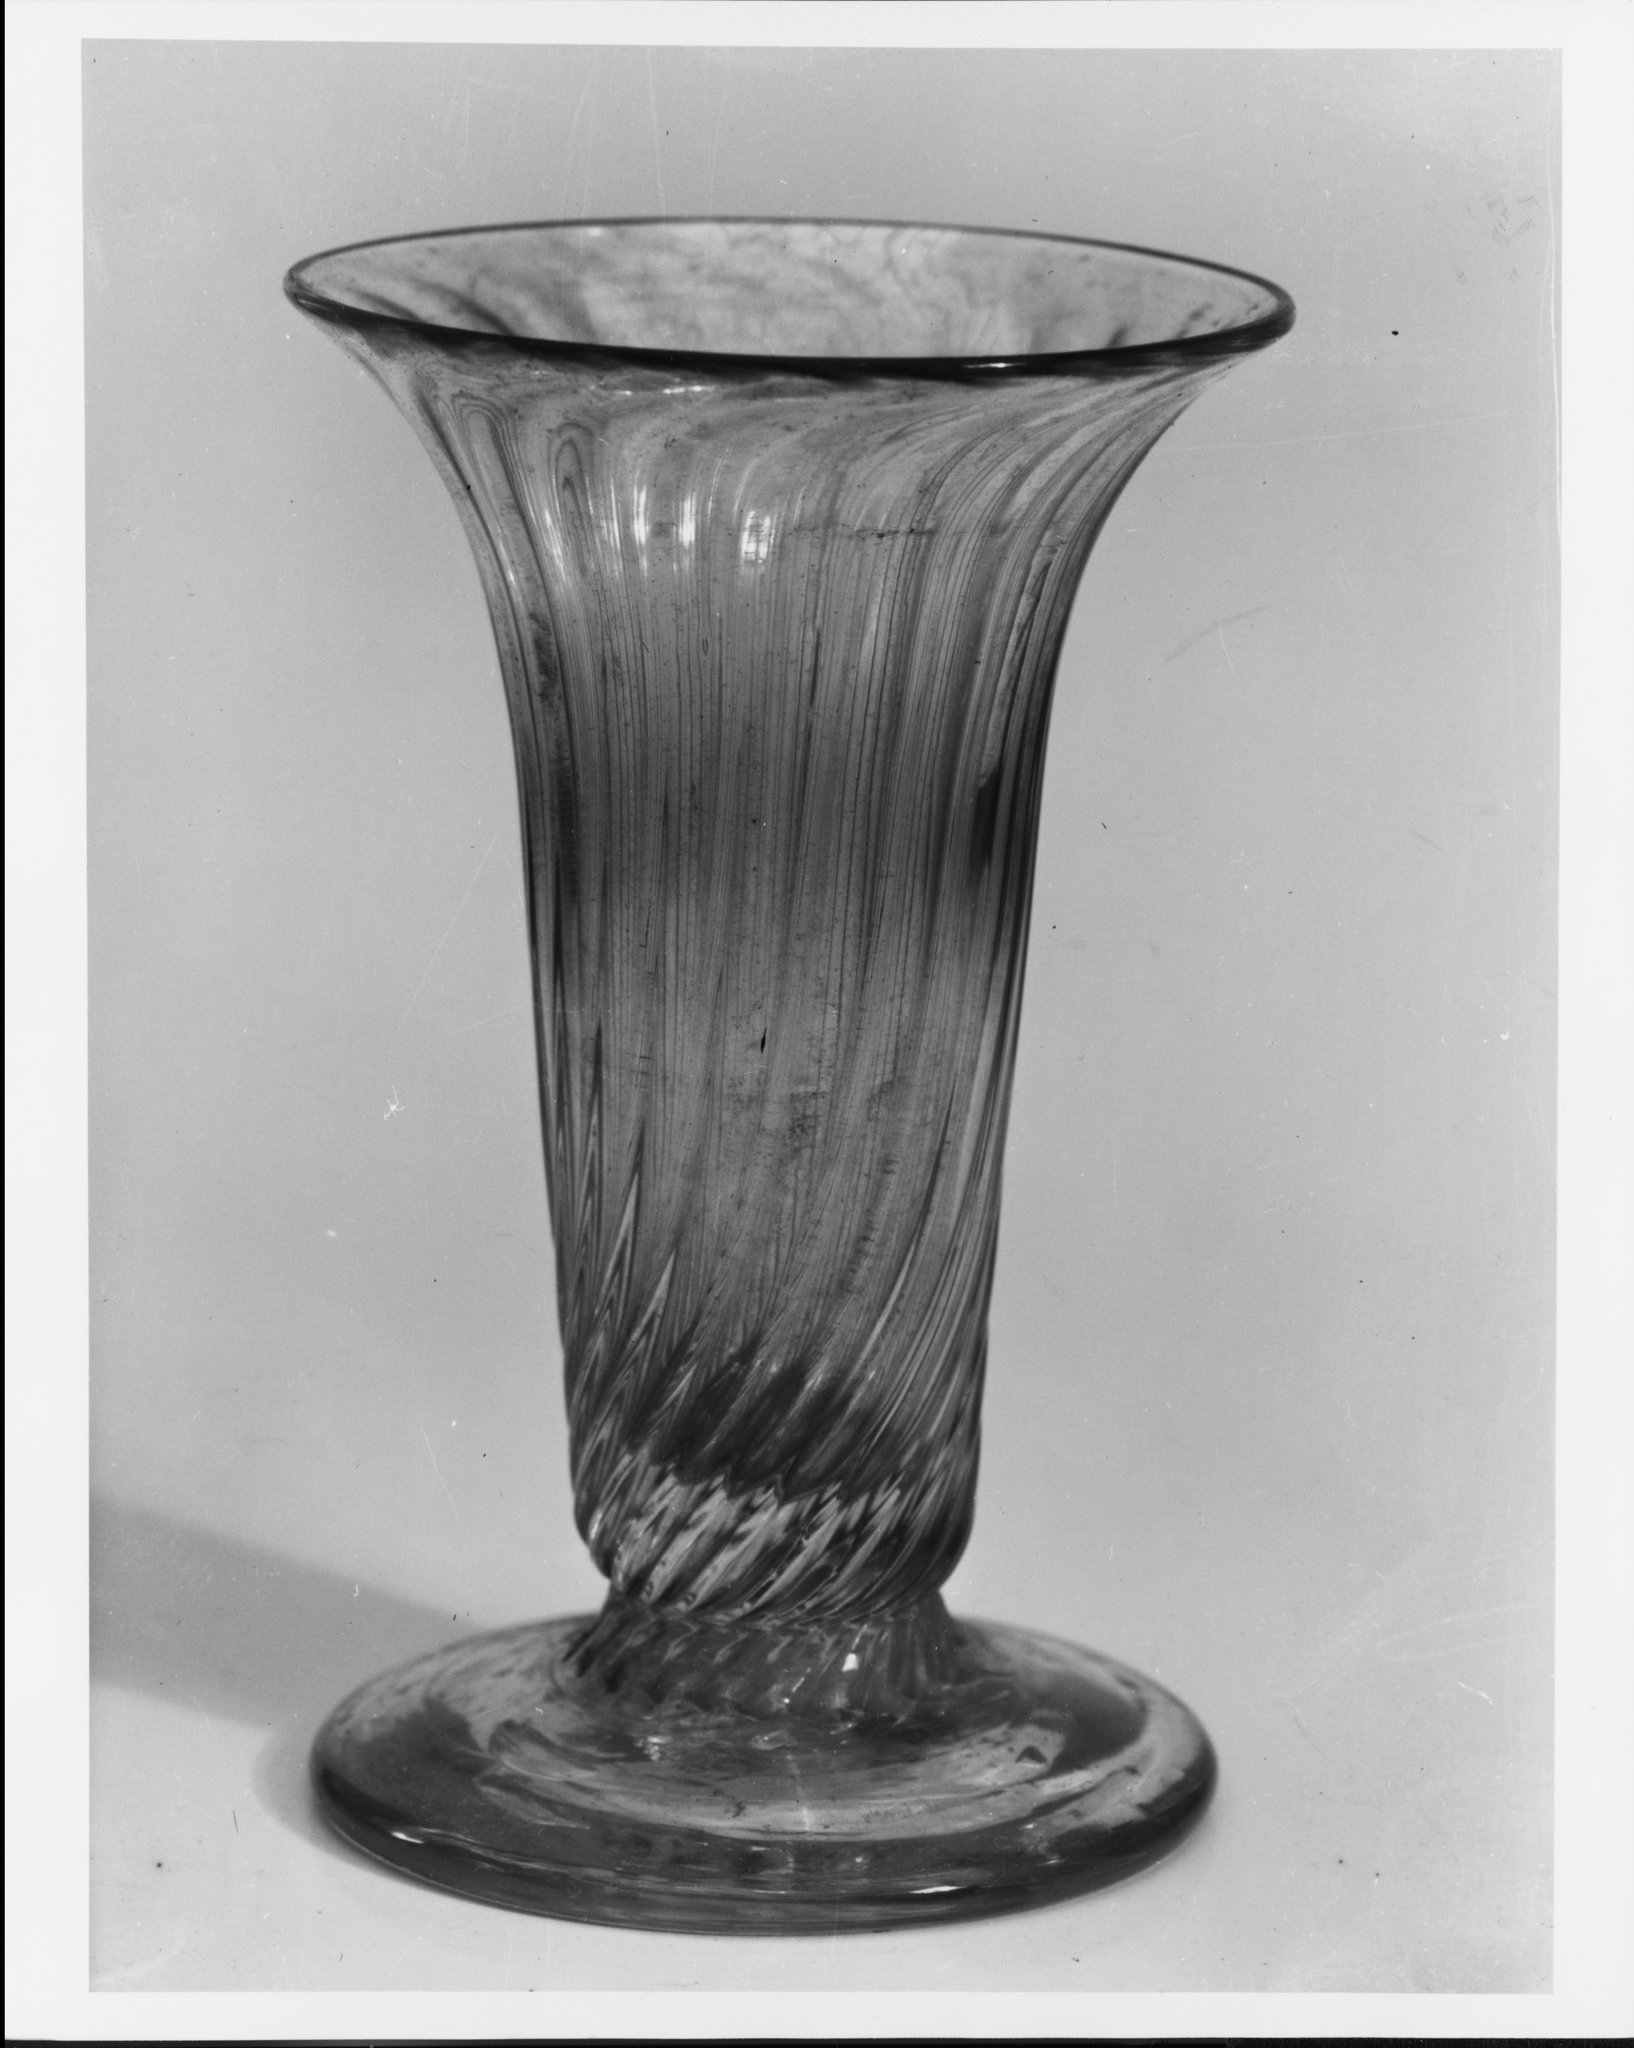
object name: jelly glass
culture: american or british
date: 1785-1825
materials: glass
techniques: glassblowing, molding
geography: england